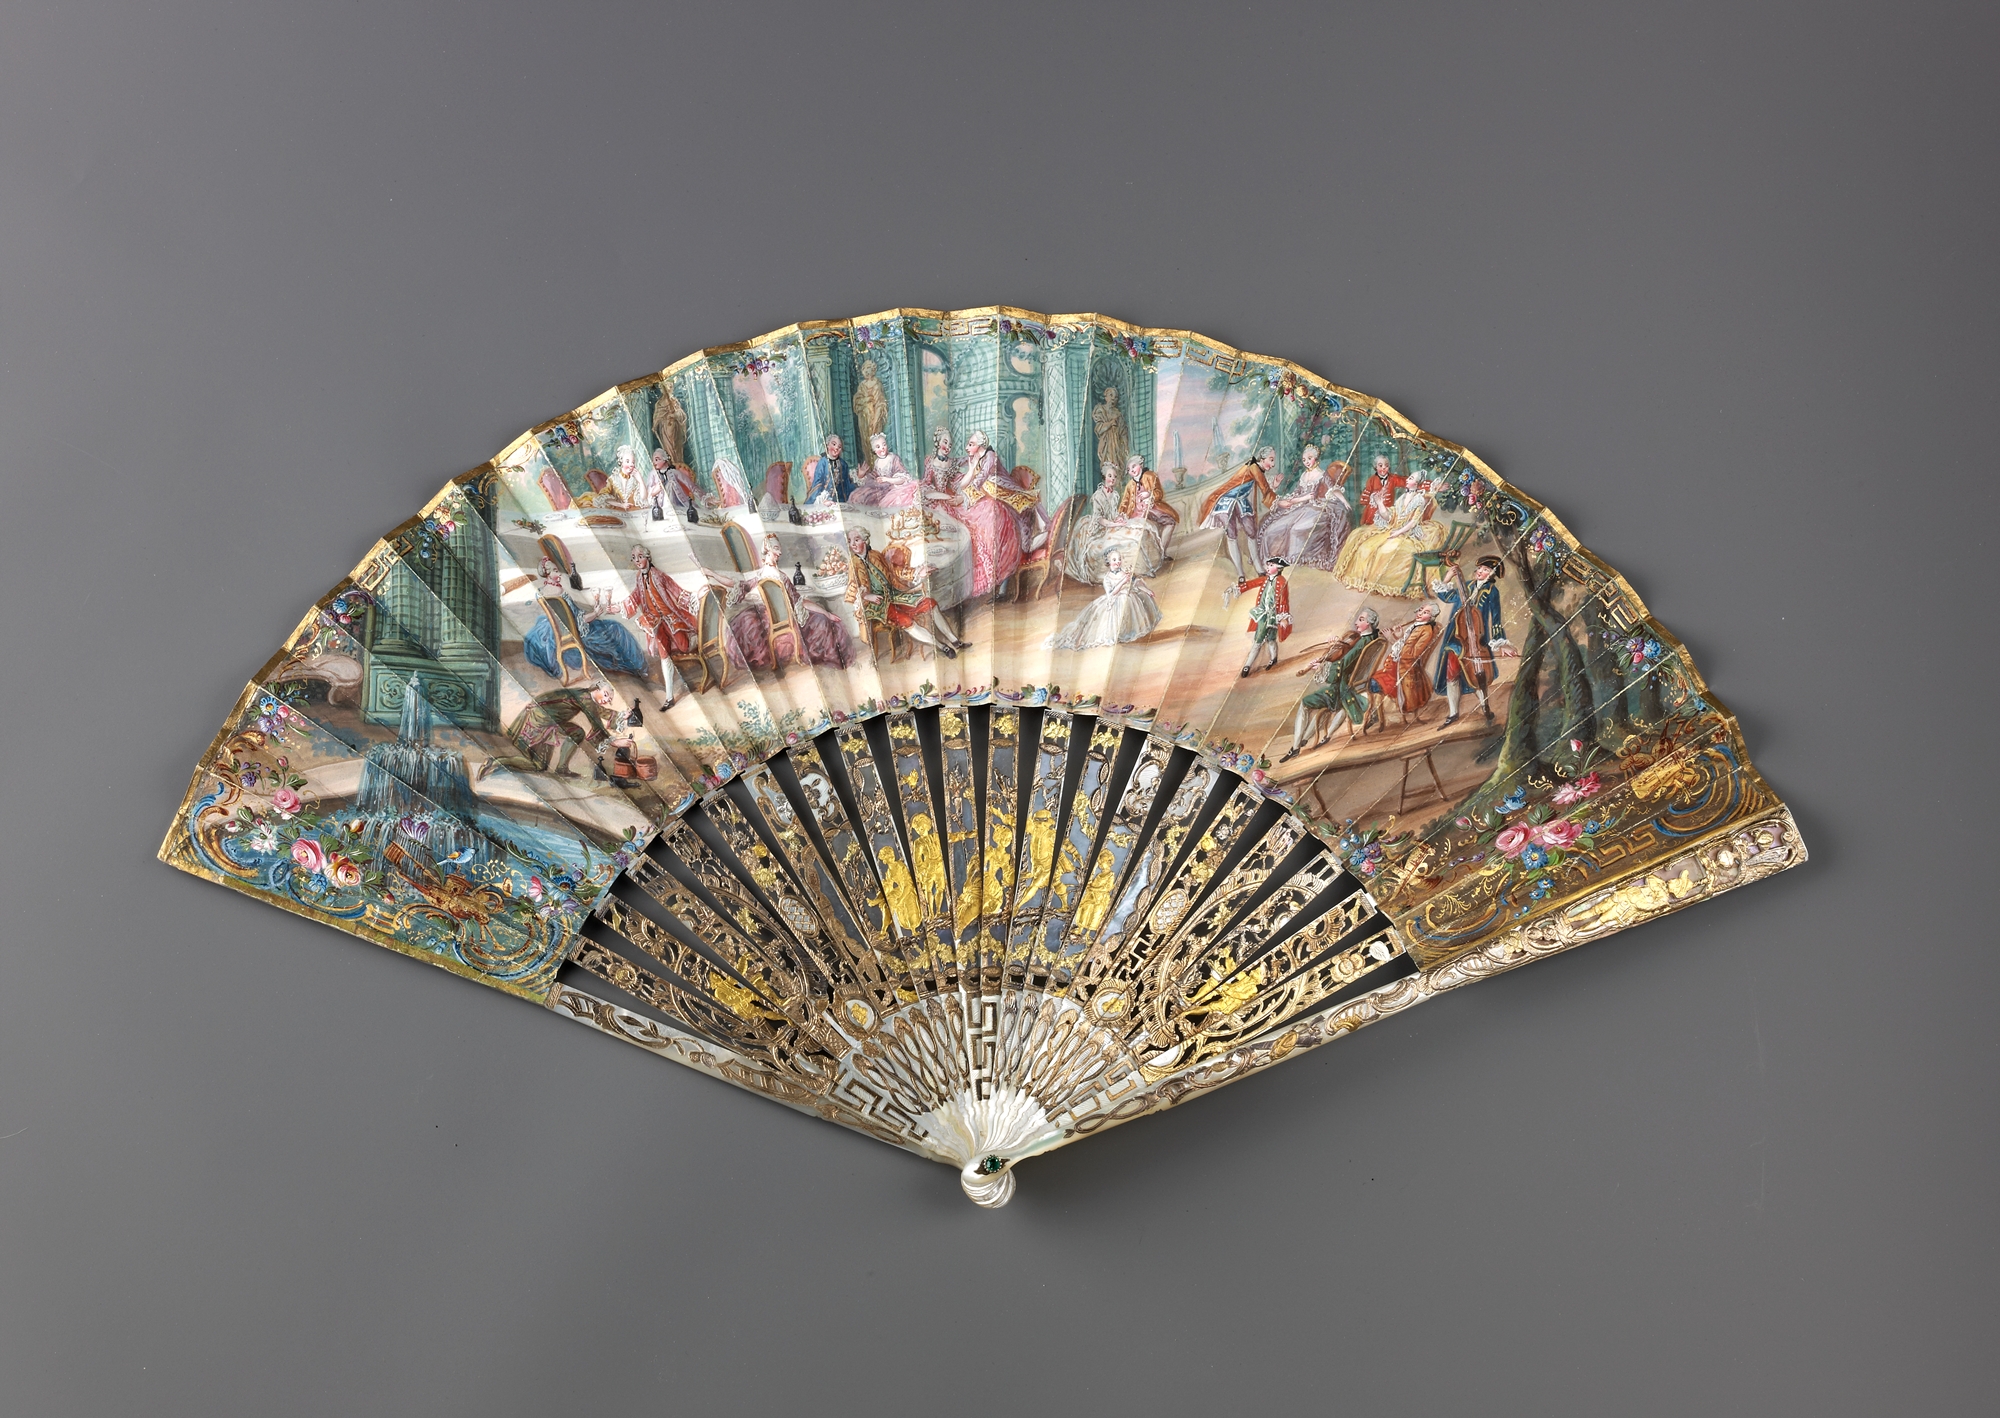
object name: fan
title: Folding fan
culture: austrian or german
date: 1760-1769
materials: bronze, gold, gouache, metal leaf, mother of pearl, paint, paper, paste, silver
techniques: carving, veneering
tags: fountains,men,women,dining,banquets